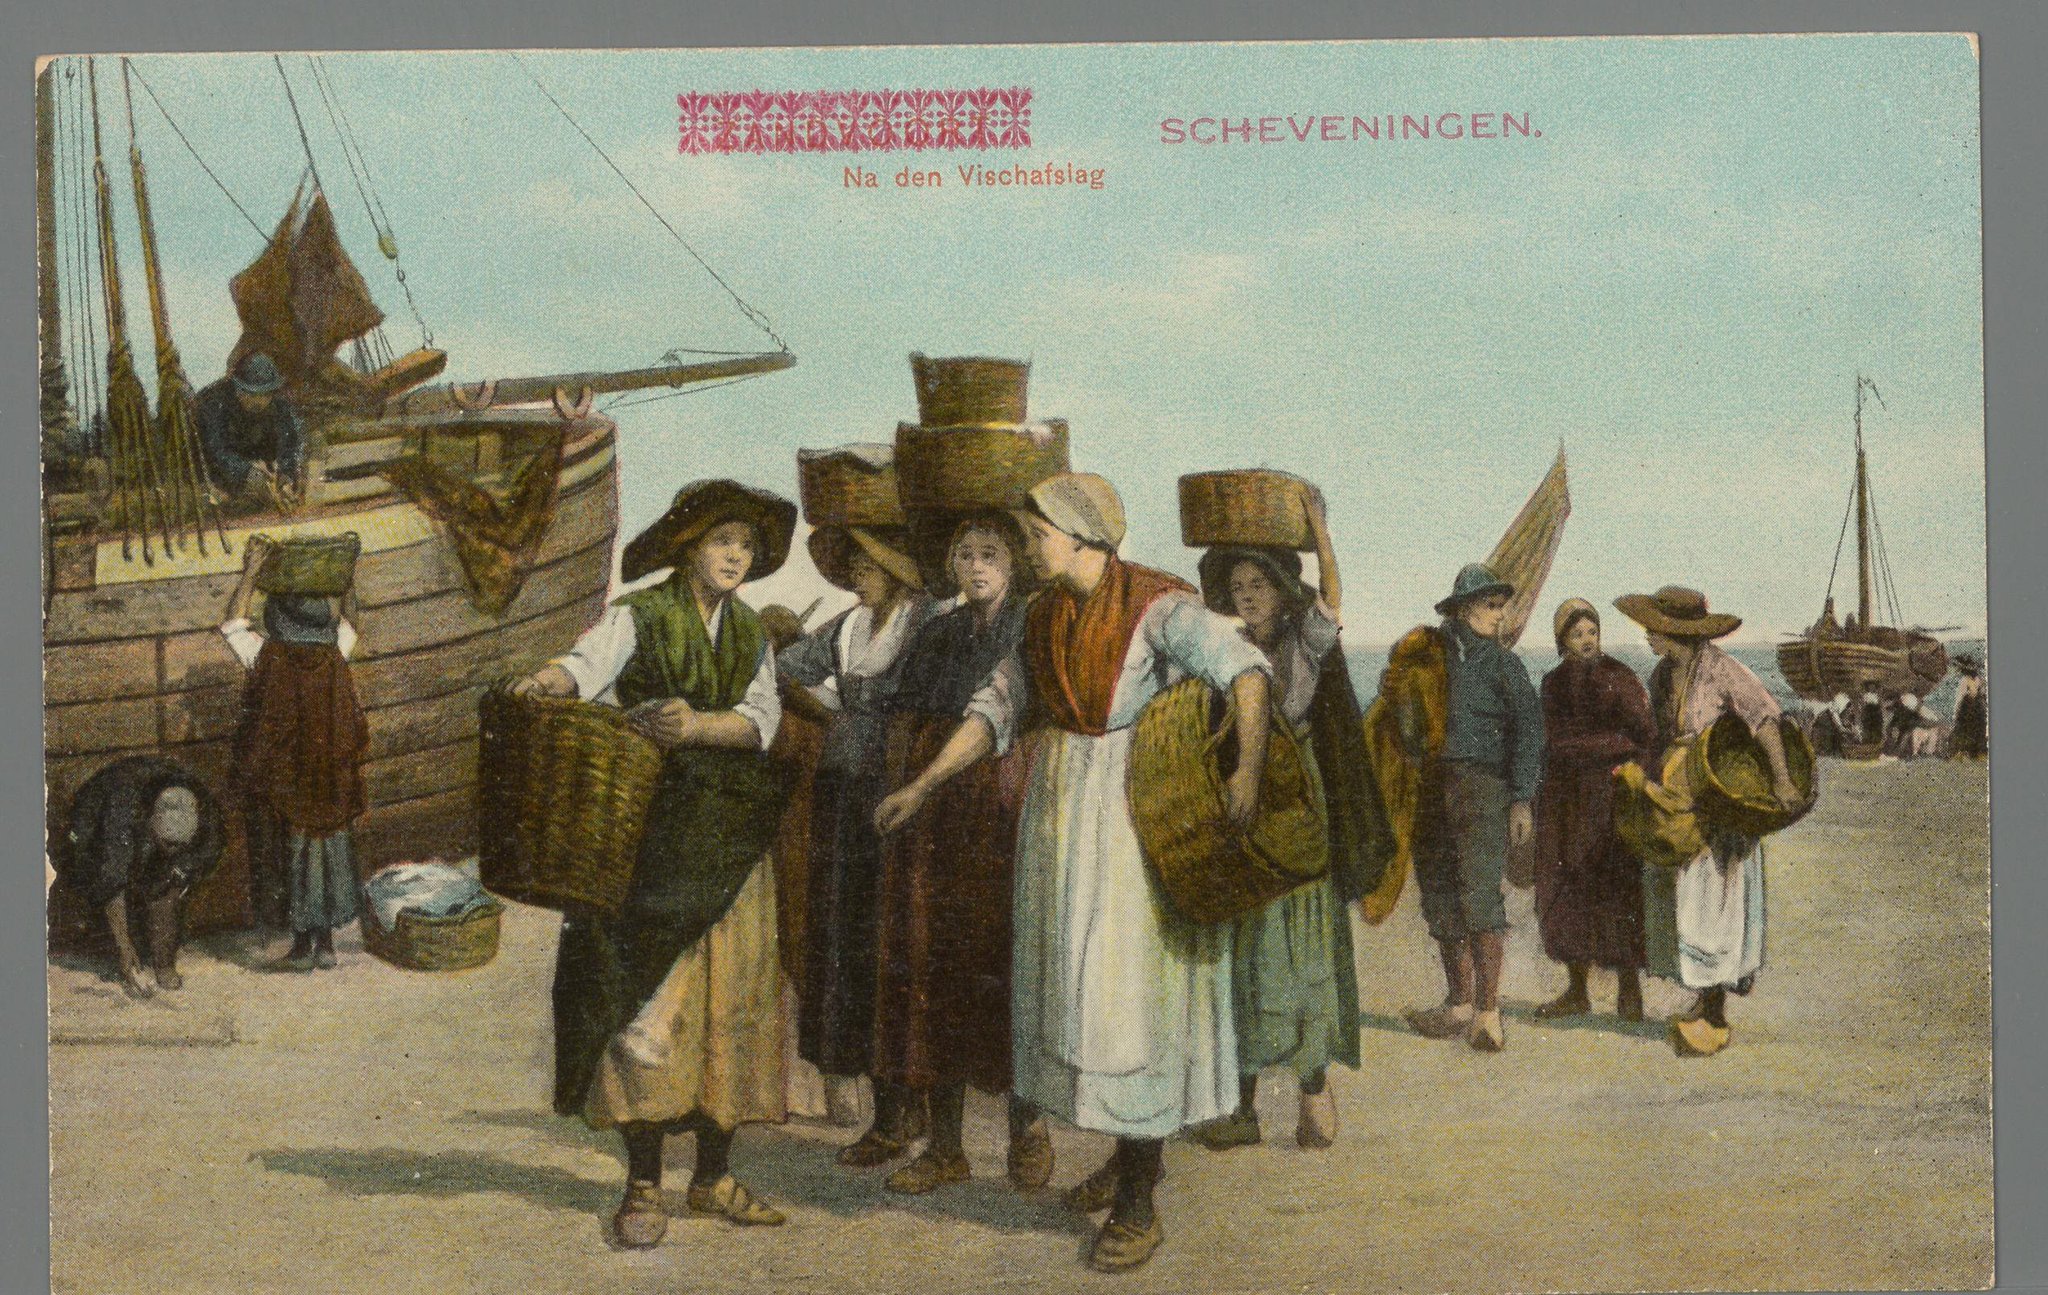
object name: photomechanical print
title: Scheveningen. Na den Vischafslag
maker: Anonymous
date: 1909-1918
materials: cardboard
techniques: lithograph, writing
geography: scheveningen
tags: beach, fisherman